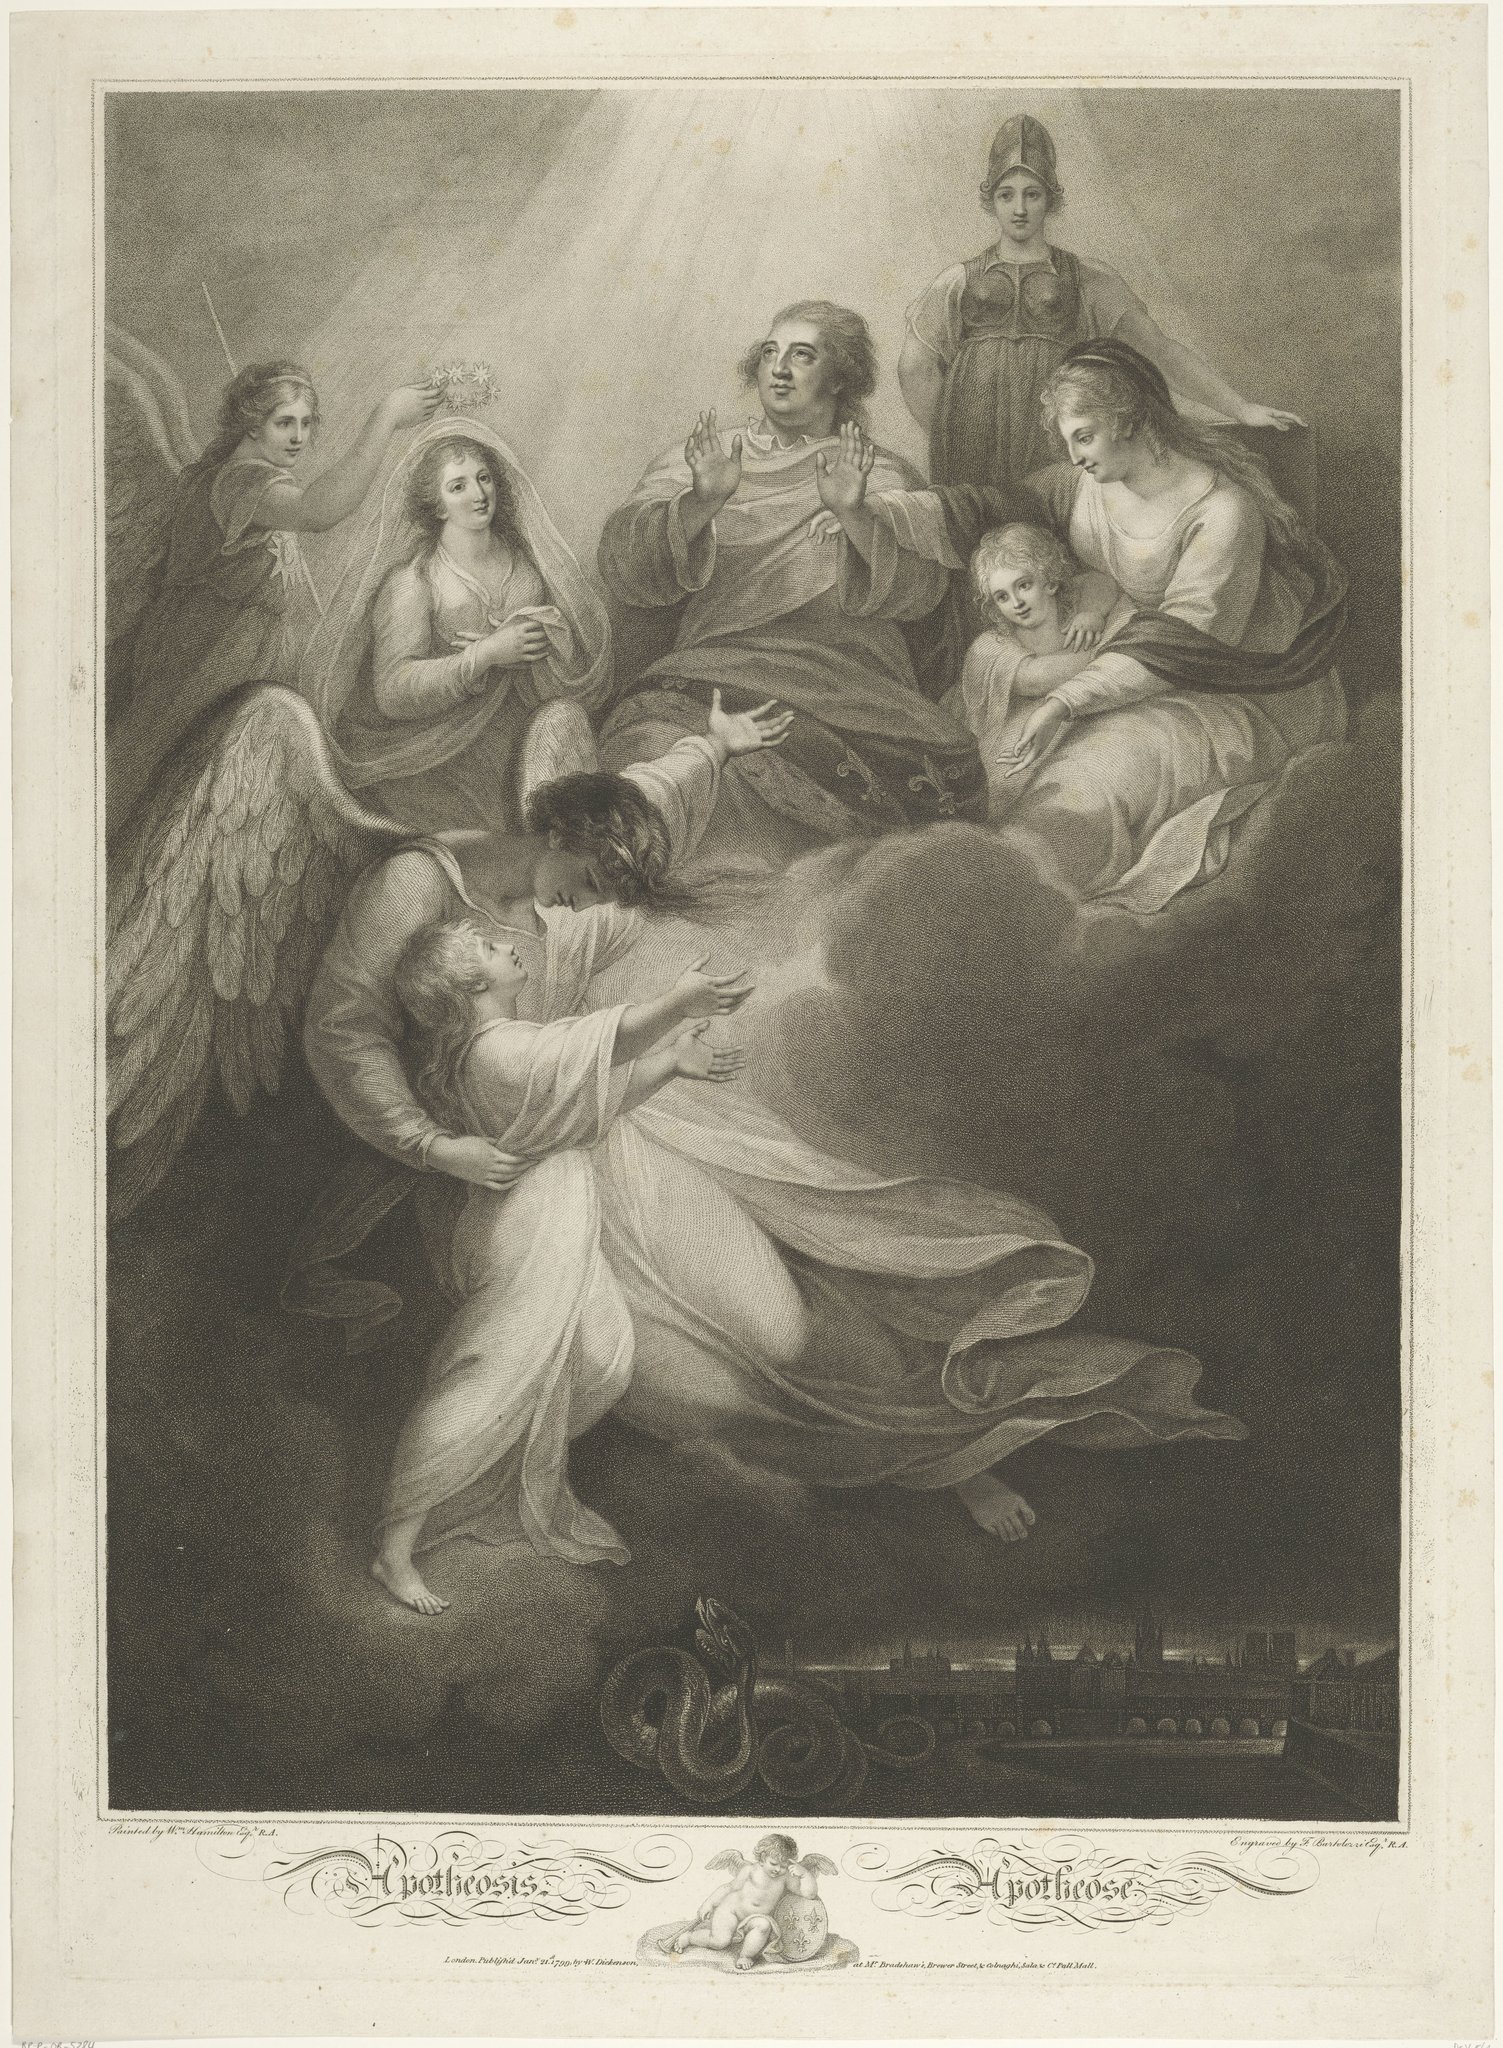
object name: print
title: Apotheose van de Franse koninklijke familie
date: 1799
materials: paper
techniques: etching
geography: london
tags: lodewijk xvi (koning van frankrijk), vienna, paris, marie antoinette, ruler, sovereign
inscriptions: collector's mark: Lugt 12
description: De Apotheose van leden van de Franse koninklijke familie op wolken. Centraal koning Lodewijk XVI, rechts Marie Antoinette en de eerste Dauphin Lodewijk Jozef en links Elizabeth die een kroon van sterren ontvangt van een engel. Midden links een beschermengel met Dauphin Lodewijk Karel (de latere koning Lodewijk XVII). Onder een slang en een gezicht op de stad Parijs.